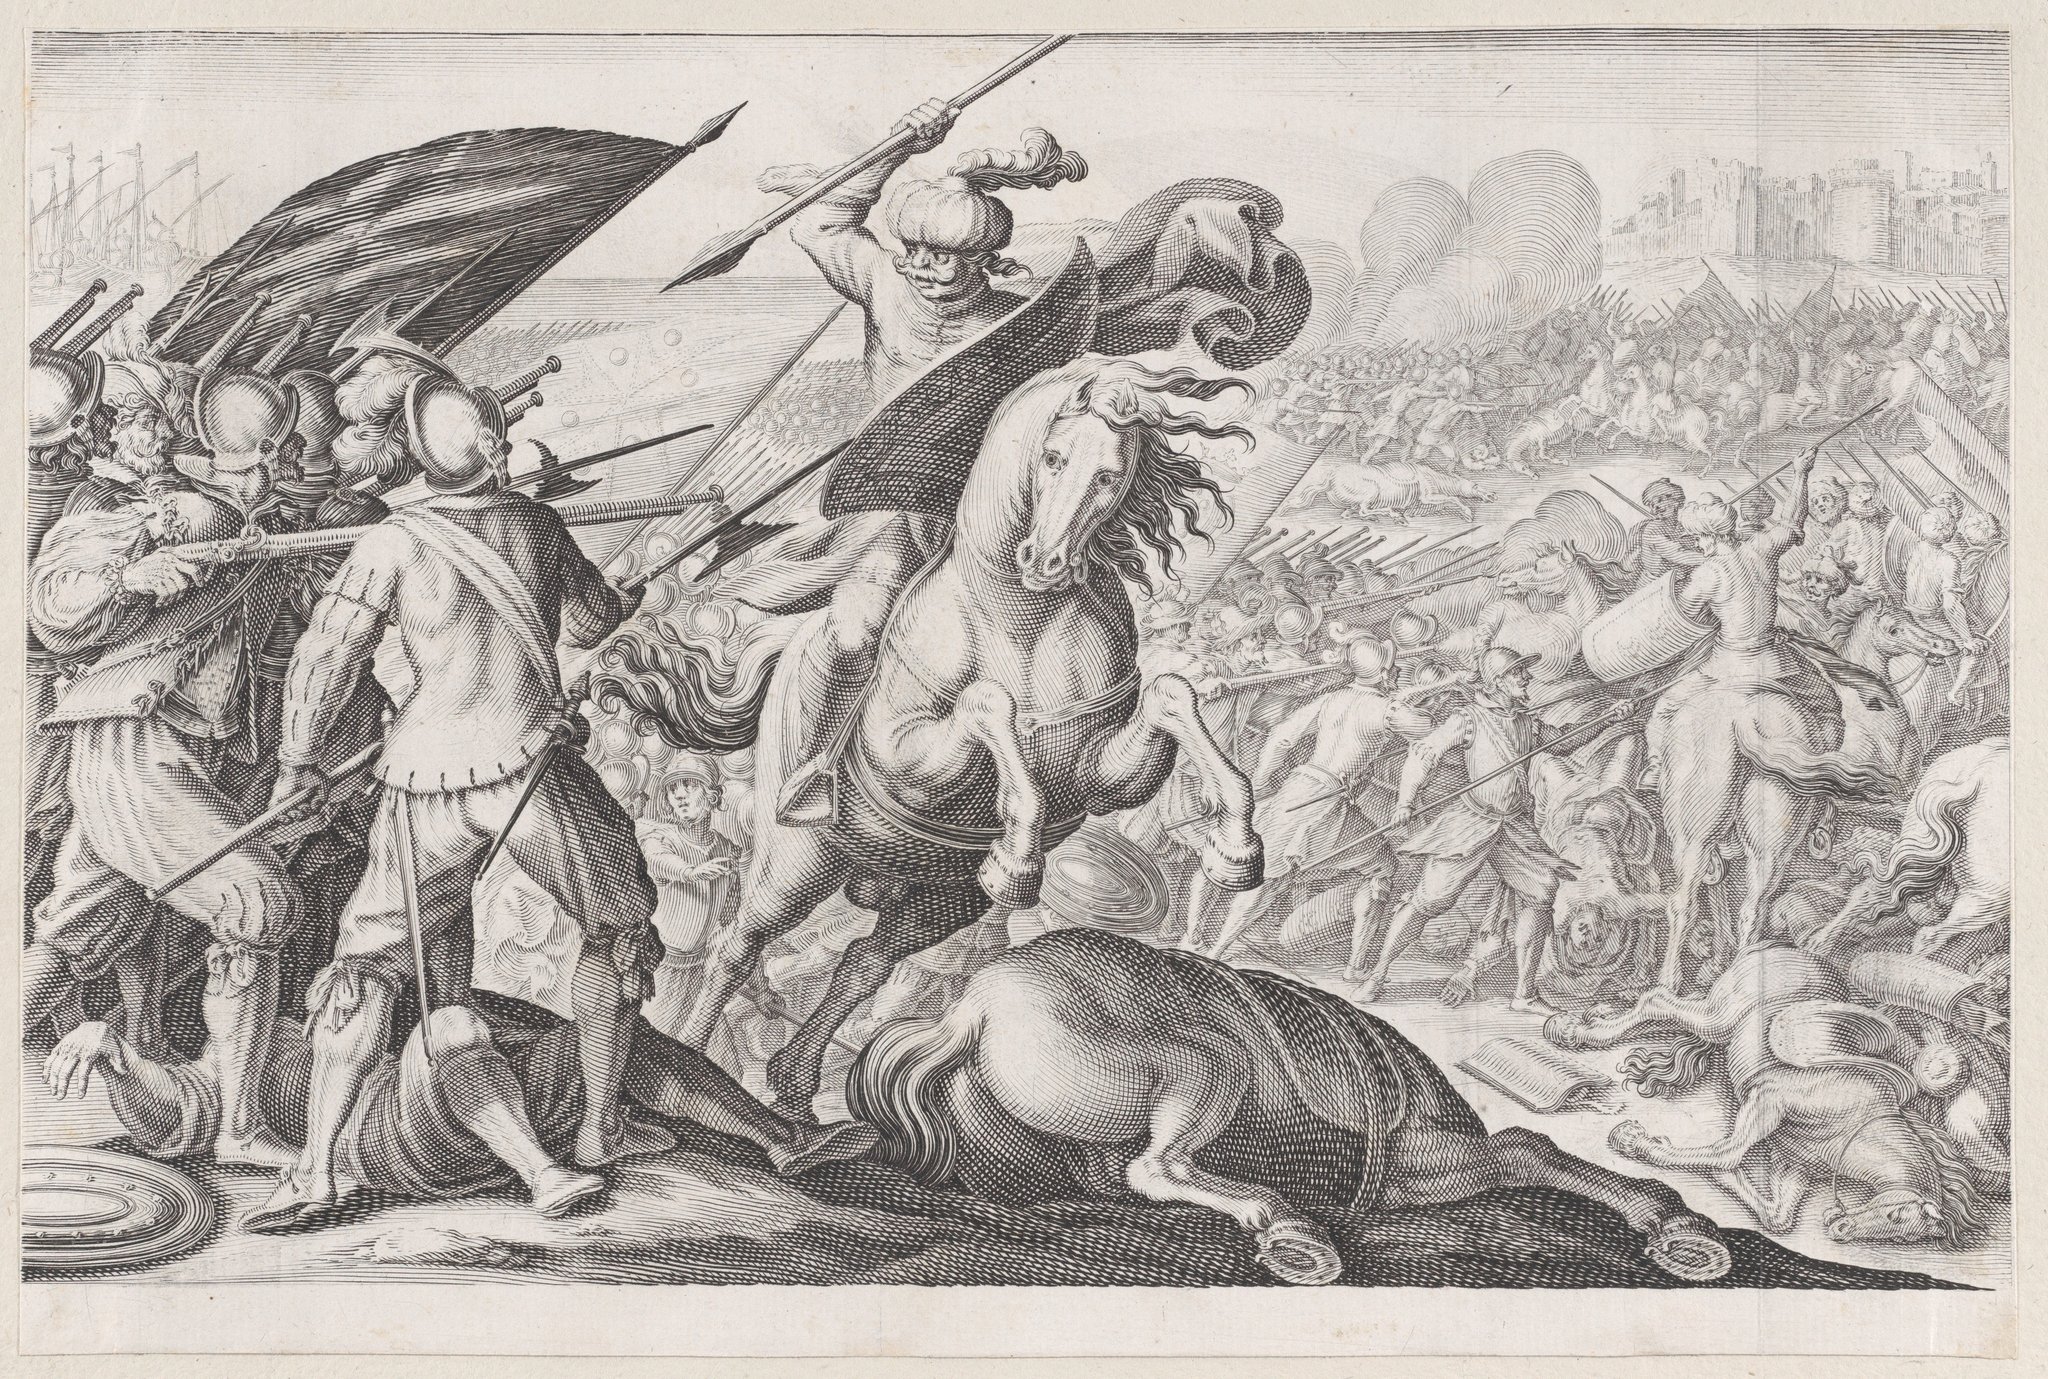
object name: print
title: Défaite de la Cavalerie Turque (Defeat of the Turkish Cavalry), from "La Vie de Ferdinand Ier de Médicis série appelée aussi Les Batailles des Médicis" (The Life of Ferdinand I de'Medici also called The Medici Battles)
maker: jacques callot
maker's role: artist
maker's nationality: french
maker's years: 1592-1635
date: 1614-1620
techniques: engraving